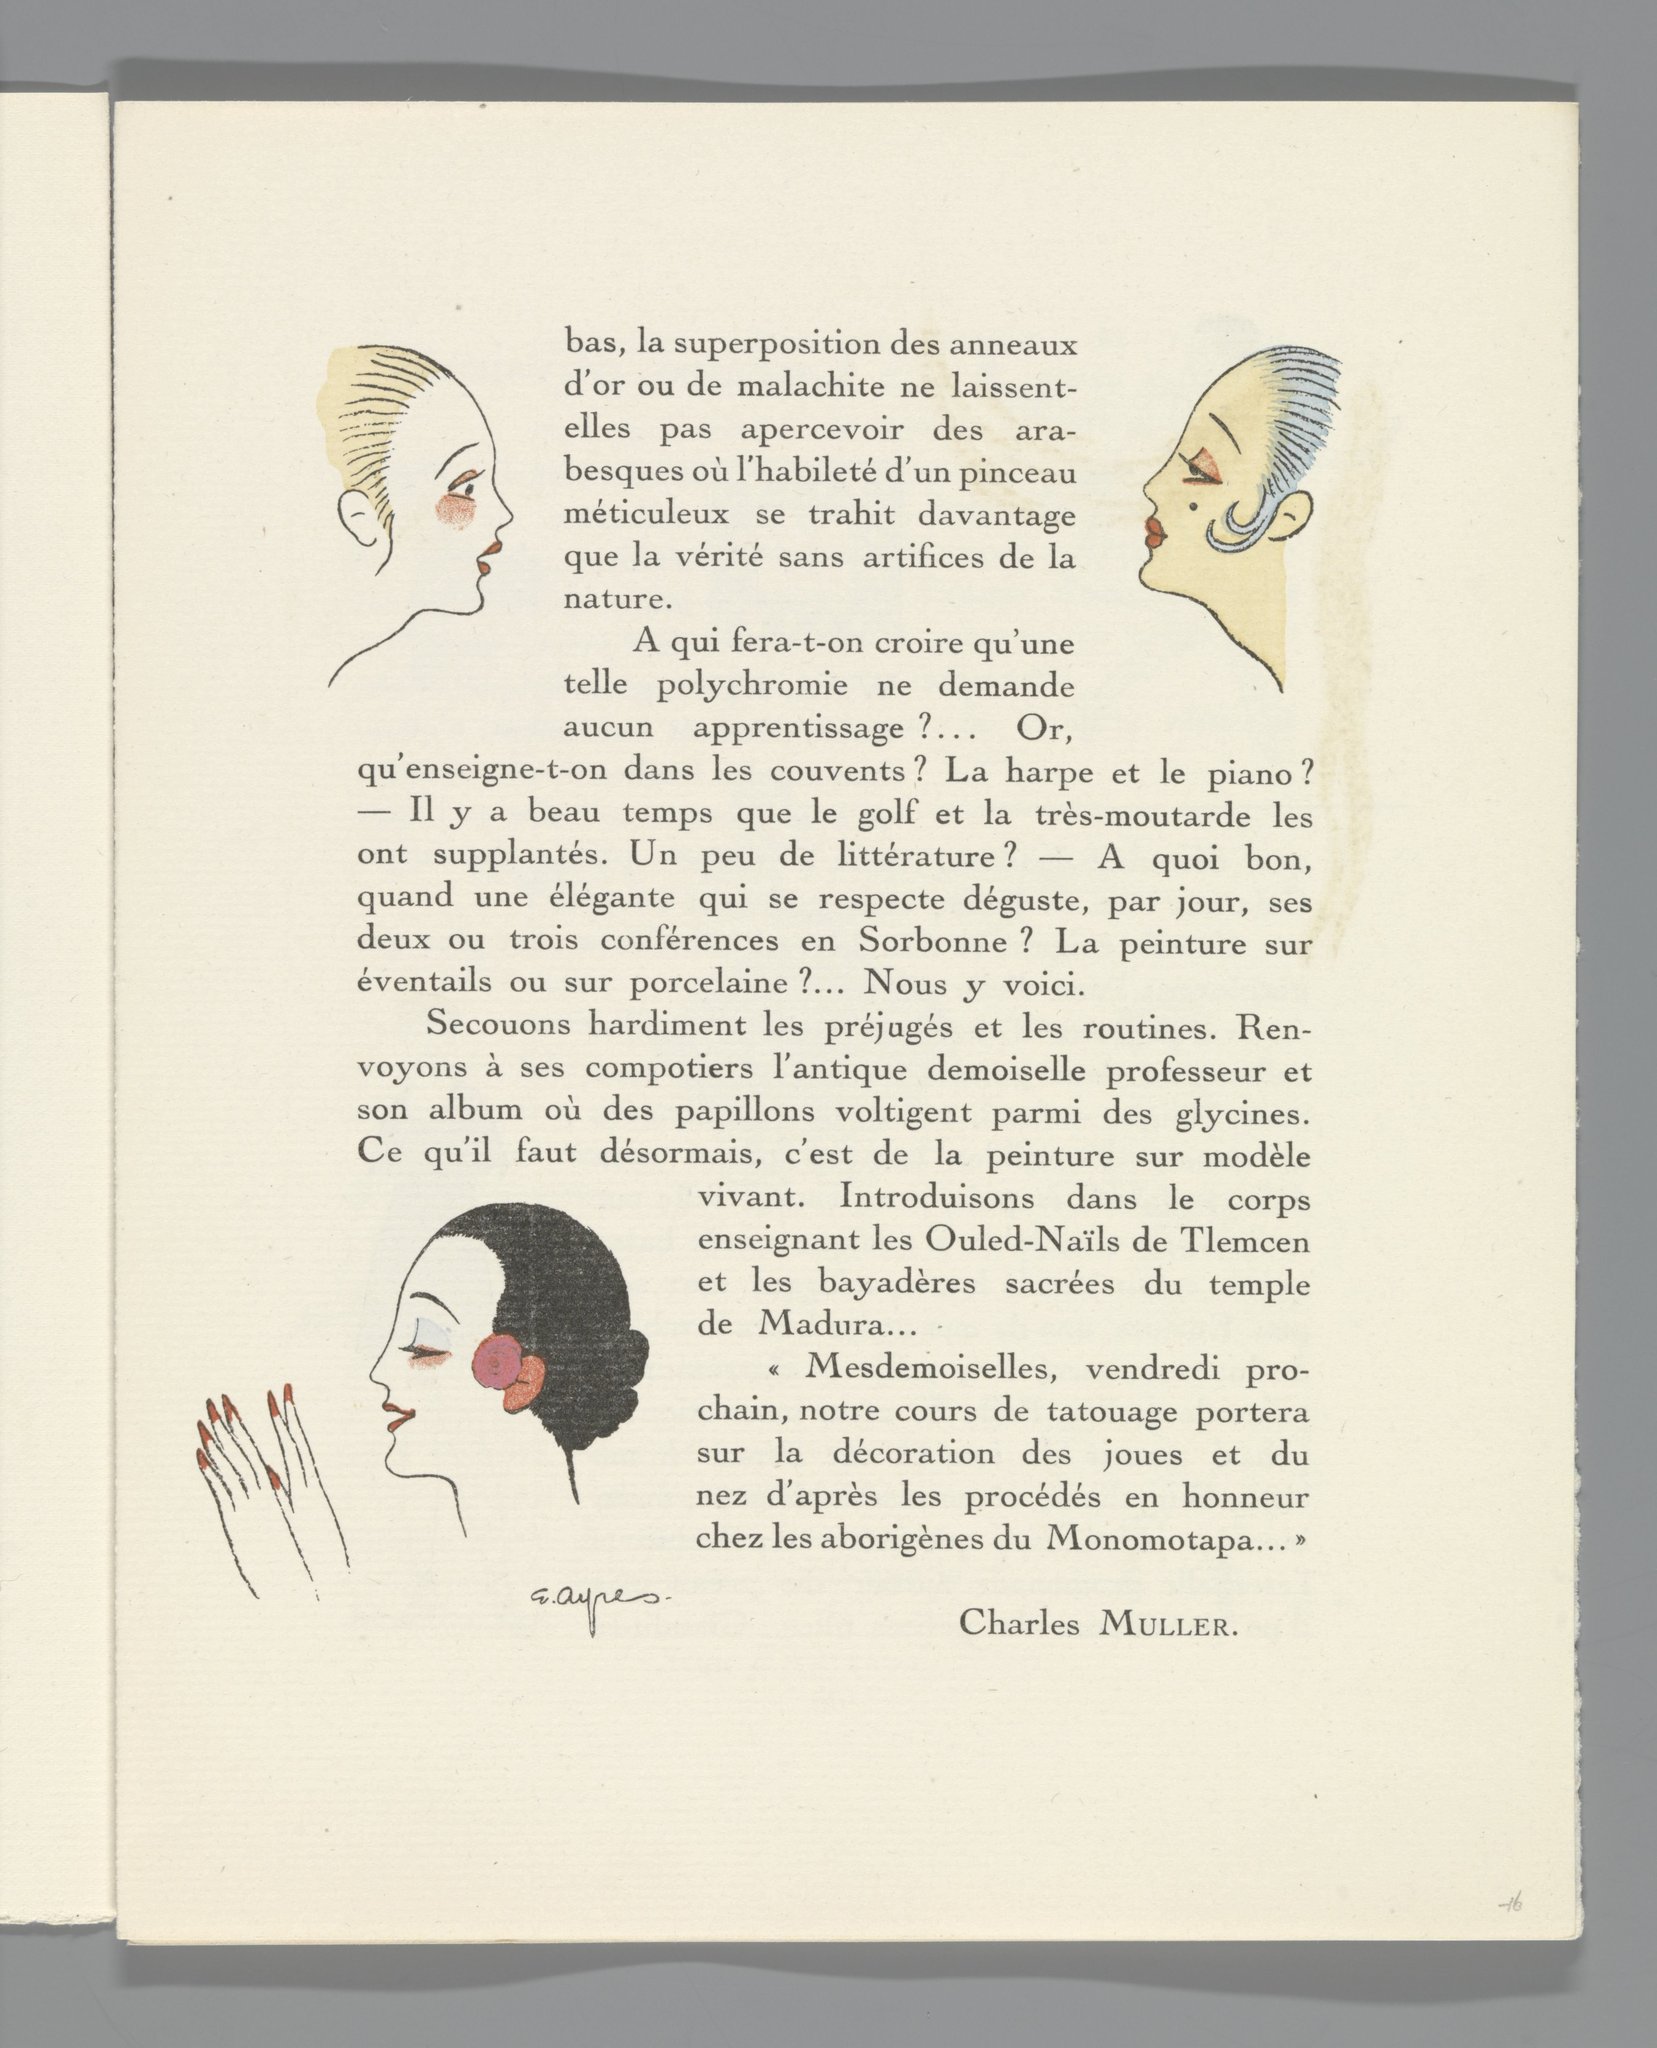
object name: fashion print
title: Gazette du Bon Ton, 1914 - No. 5, pag. 157: La Palette des Dames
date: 1914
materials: paper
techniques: hand coloring, letterpress printing, lithograph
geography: paris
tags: fashion plates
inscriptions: date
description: La Palette des Dames. Tekst van Chales Muller met ills. Pag. 157 uit Gazette du Bon Ton 1914, No. 5.